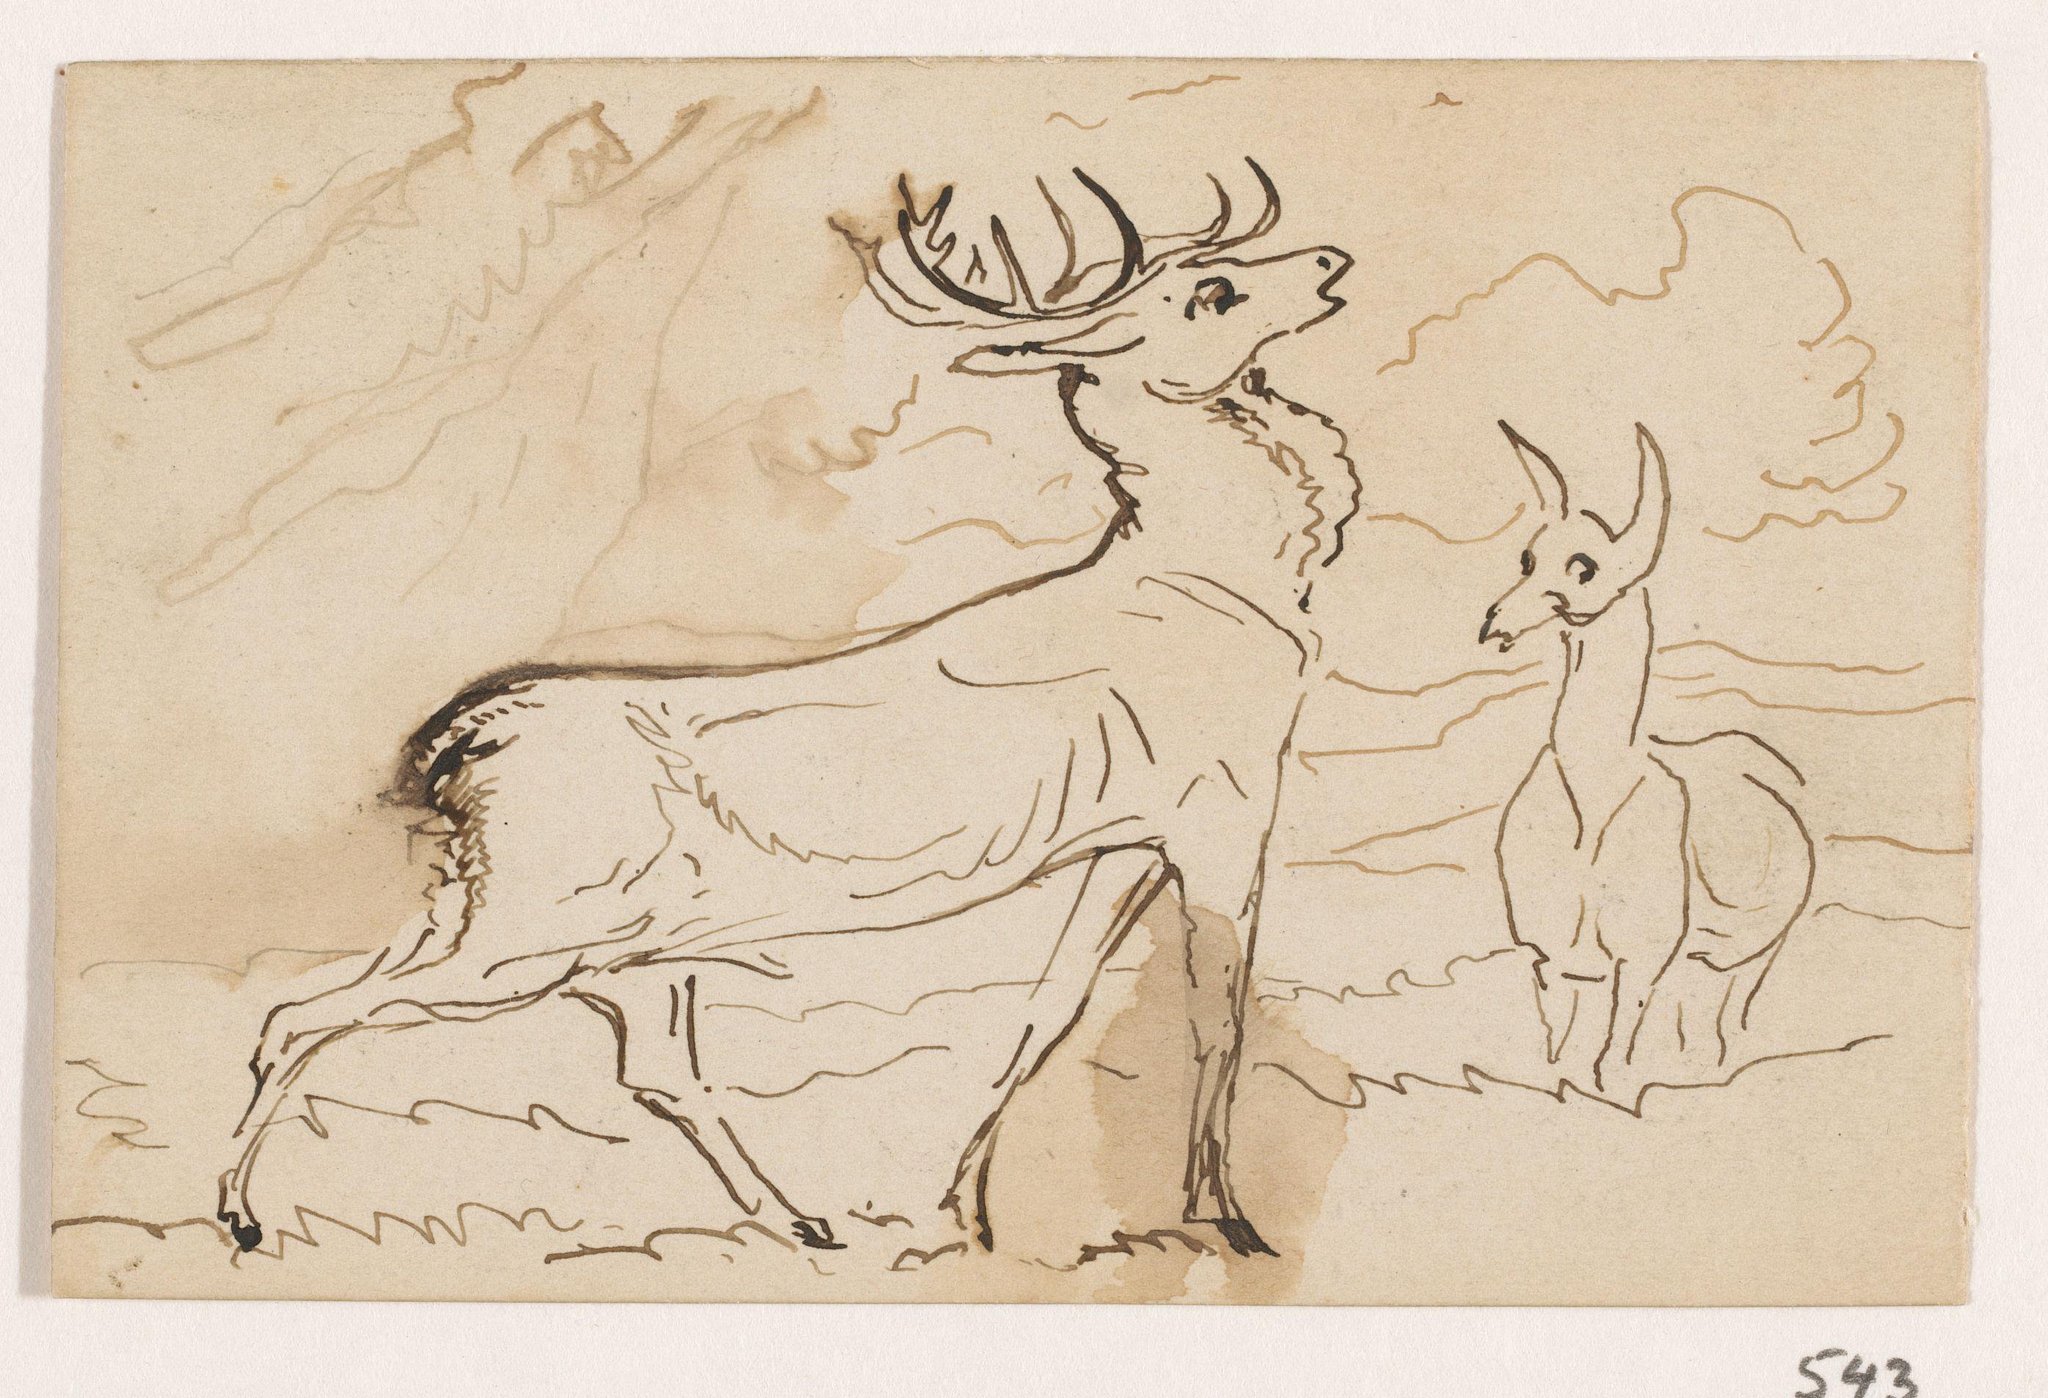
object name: drawing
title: Herten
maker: johannes tavenraat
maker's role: draughtsman, painter, print maker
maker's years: 1809-1881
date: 1866-1880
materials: ink, paper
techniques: brush, pen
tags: hoofed animals: deer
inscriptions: collector's mark: Lugt 2228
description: Herten. Getekend op de achterzijde van een visitekaartje van de firma 'A. Crols & Cie te Boxtel' met de datum 1866.